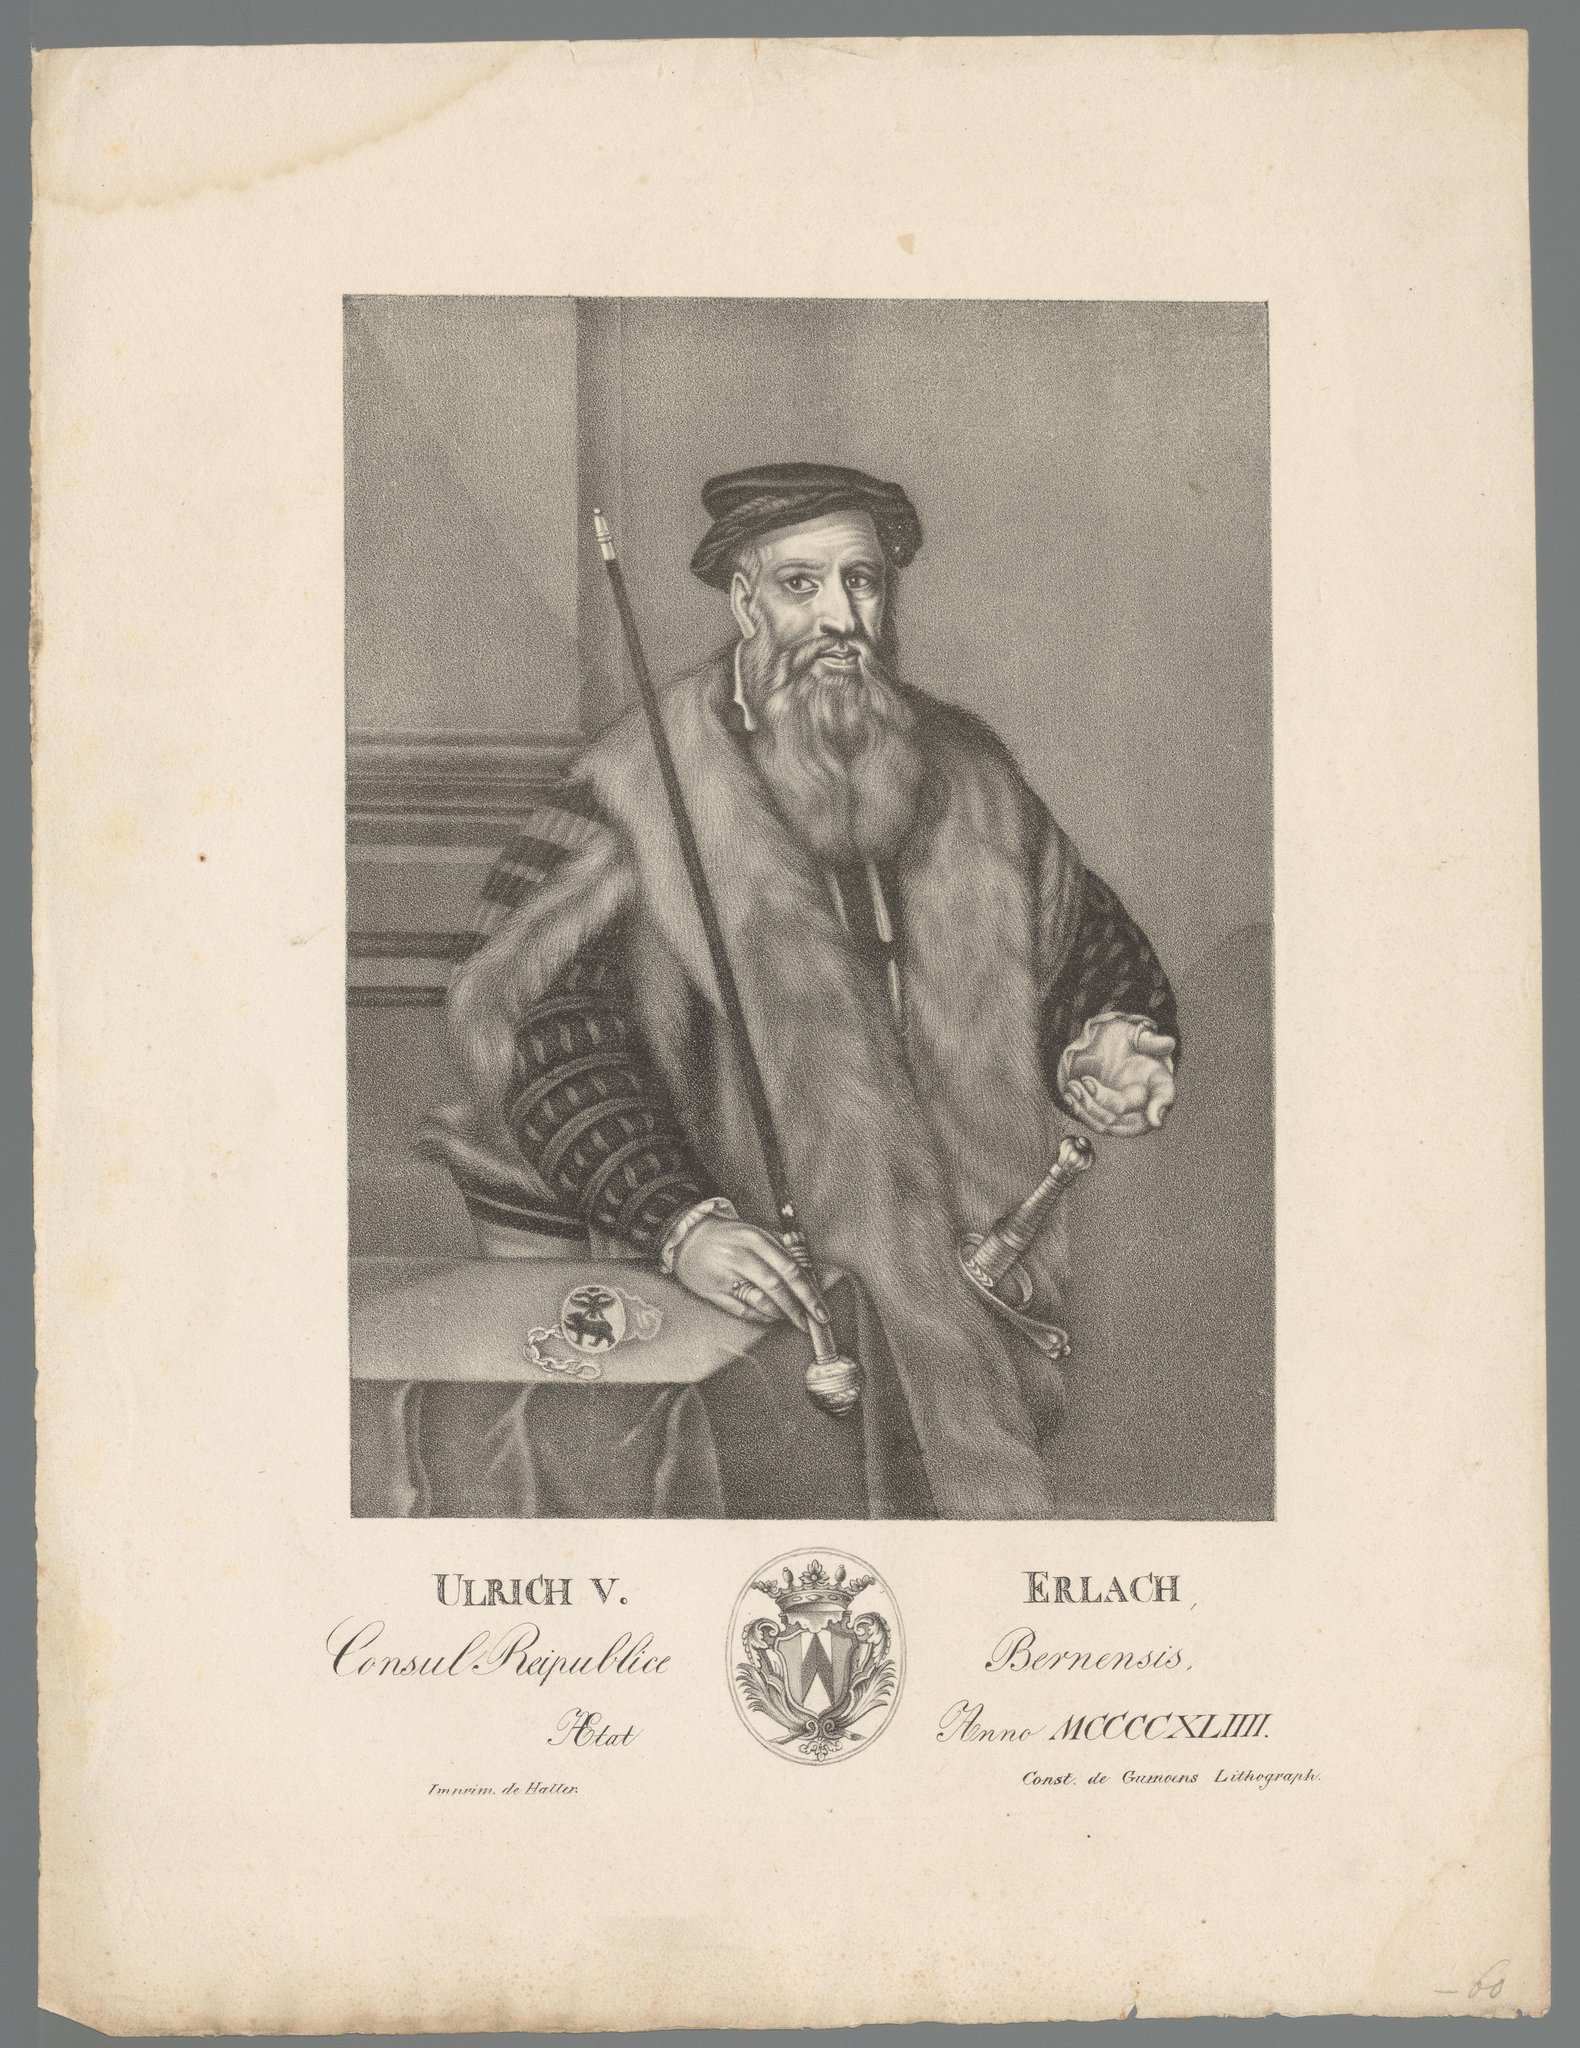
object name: print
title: Portret van Ulrich von Erlach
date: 1813-1864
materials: paper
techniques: lithograph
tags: adult man, historical persons, beard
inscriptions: collector's mark: Lugt 2228